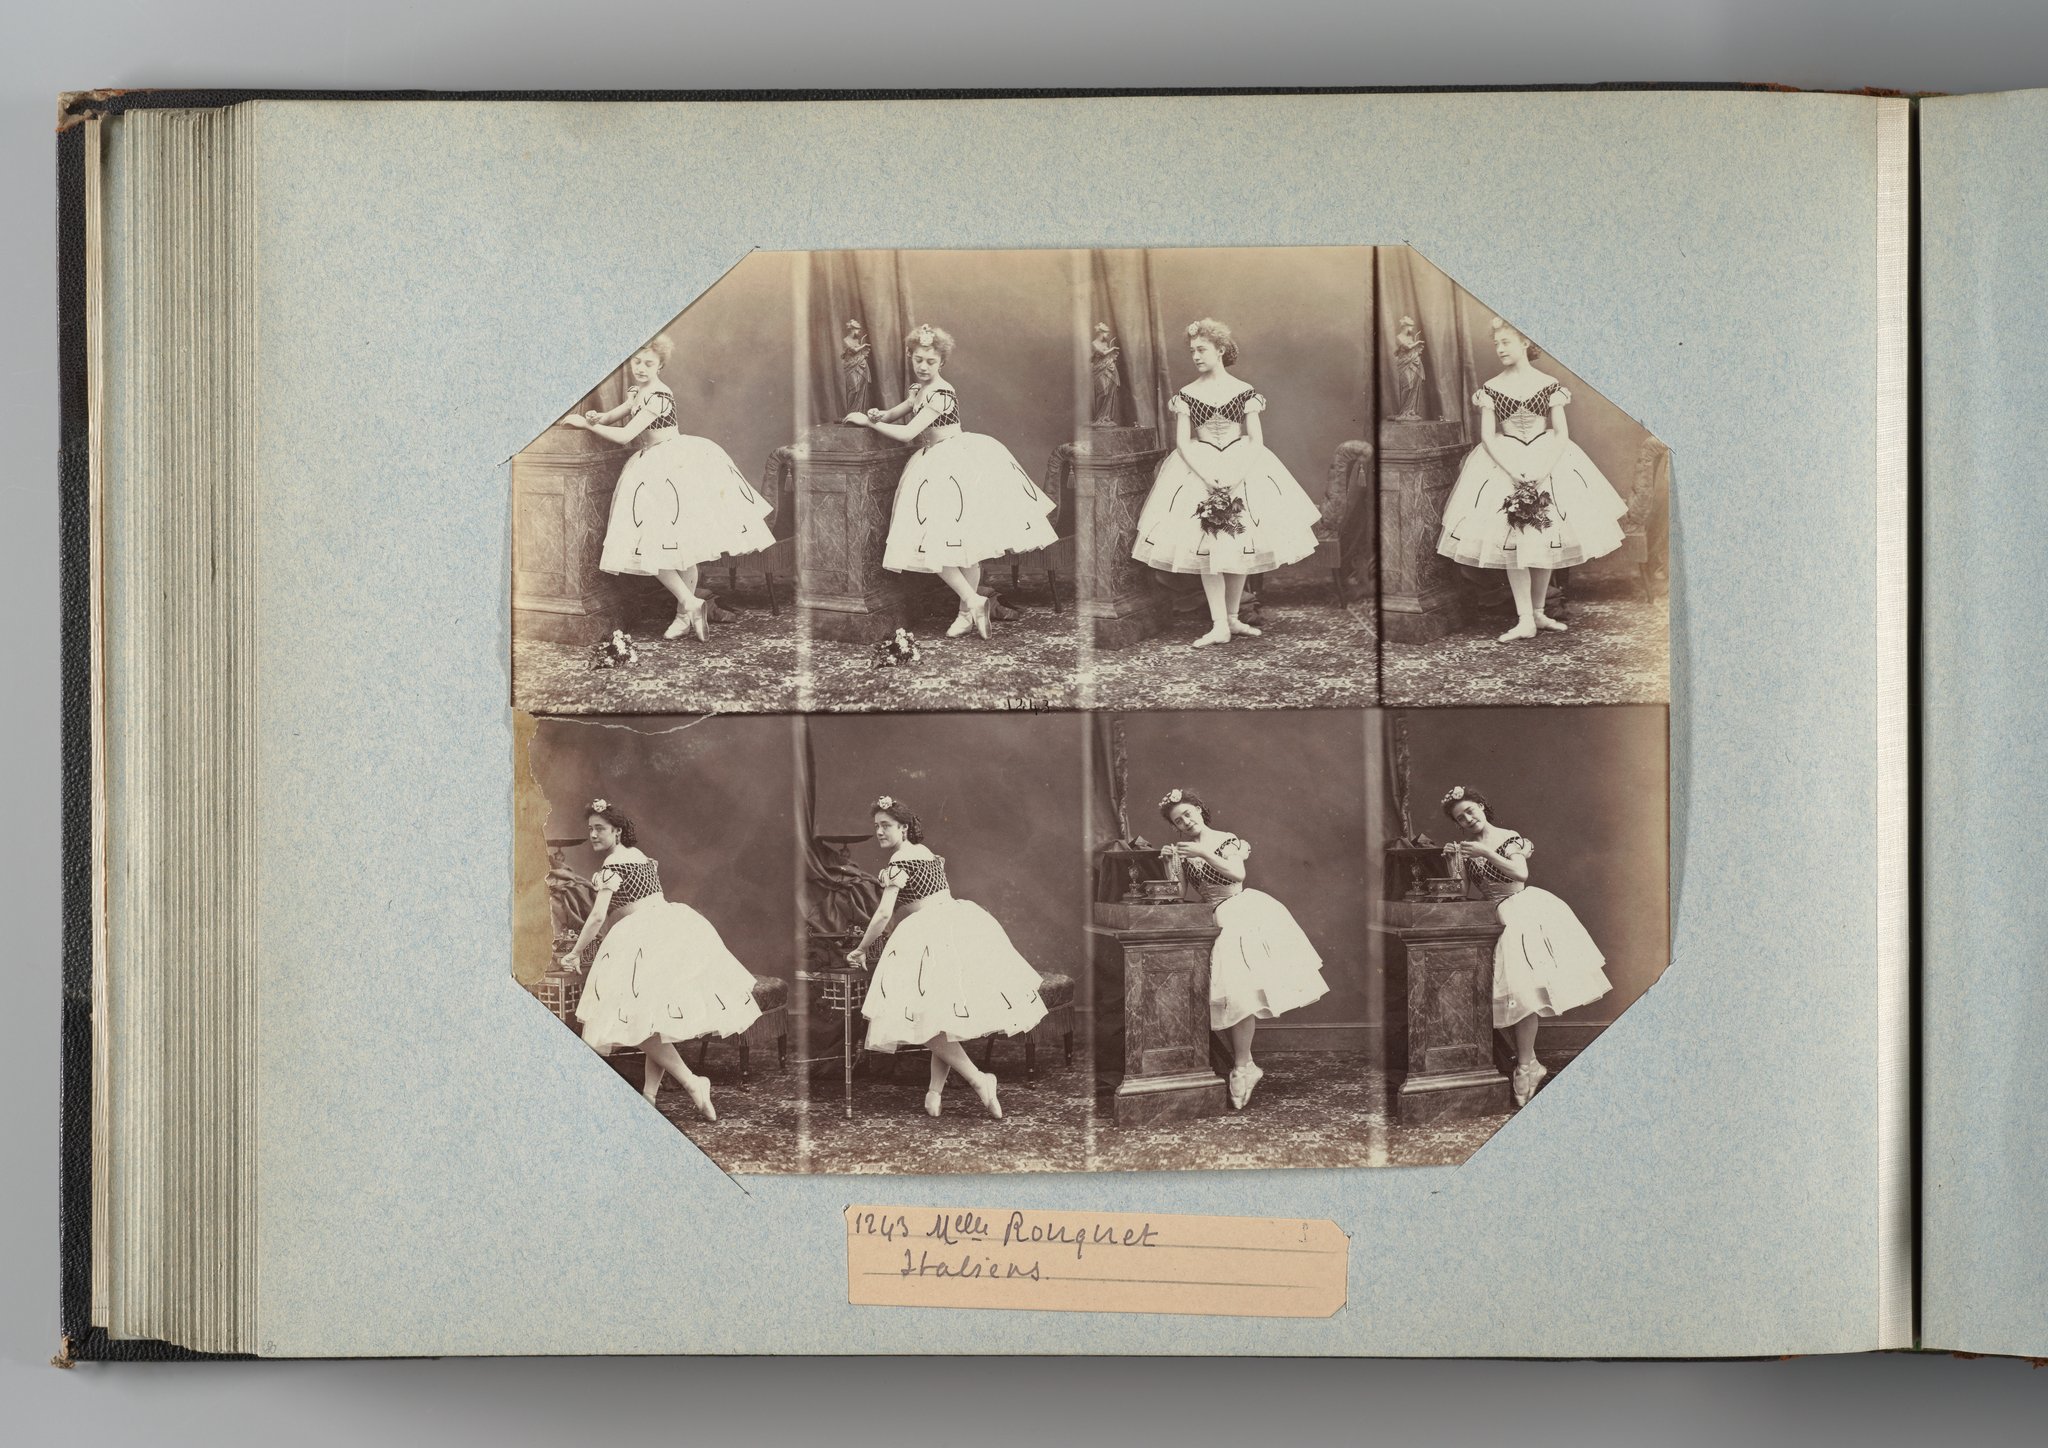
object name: photograph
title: Mlle Rouquet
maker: andré-adolphe-eugène disdéri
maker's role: artist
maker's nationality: french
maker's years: 1819-1889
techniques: albumen silver print, glass negative